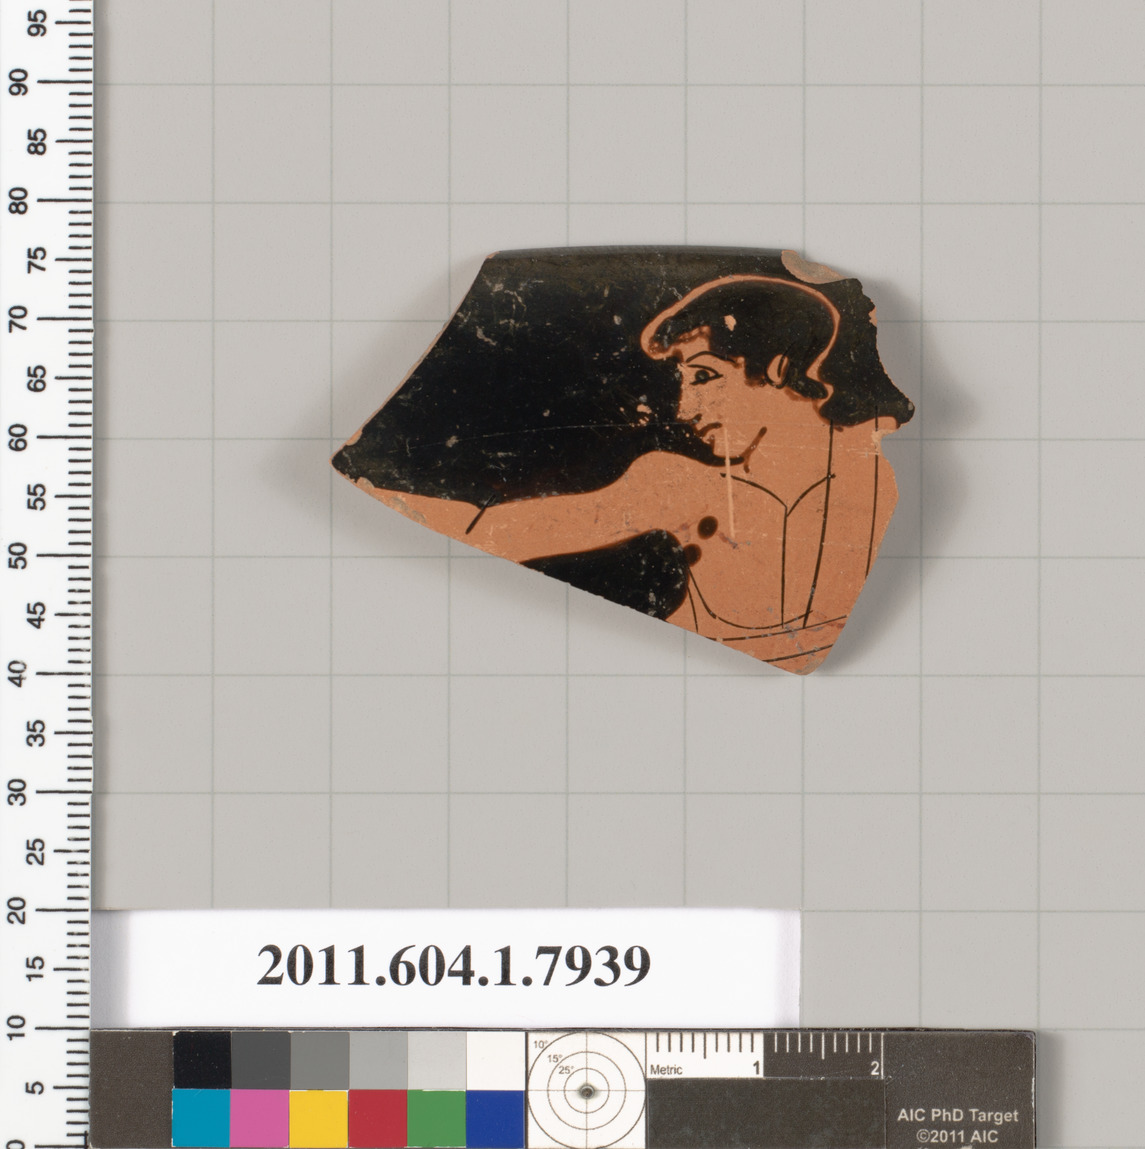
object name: kylix fragment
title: Terracotta rim fragment of a kylix (drinking cup)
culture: greek, attic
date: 467-435 BCE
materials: terracotta